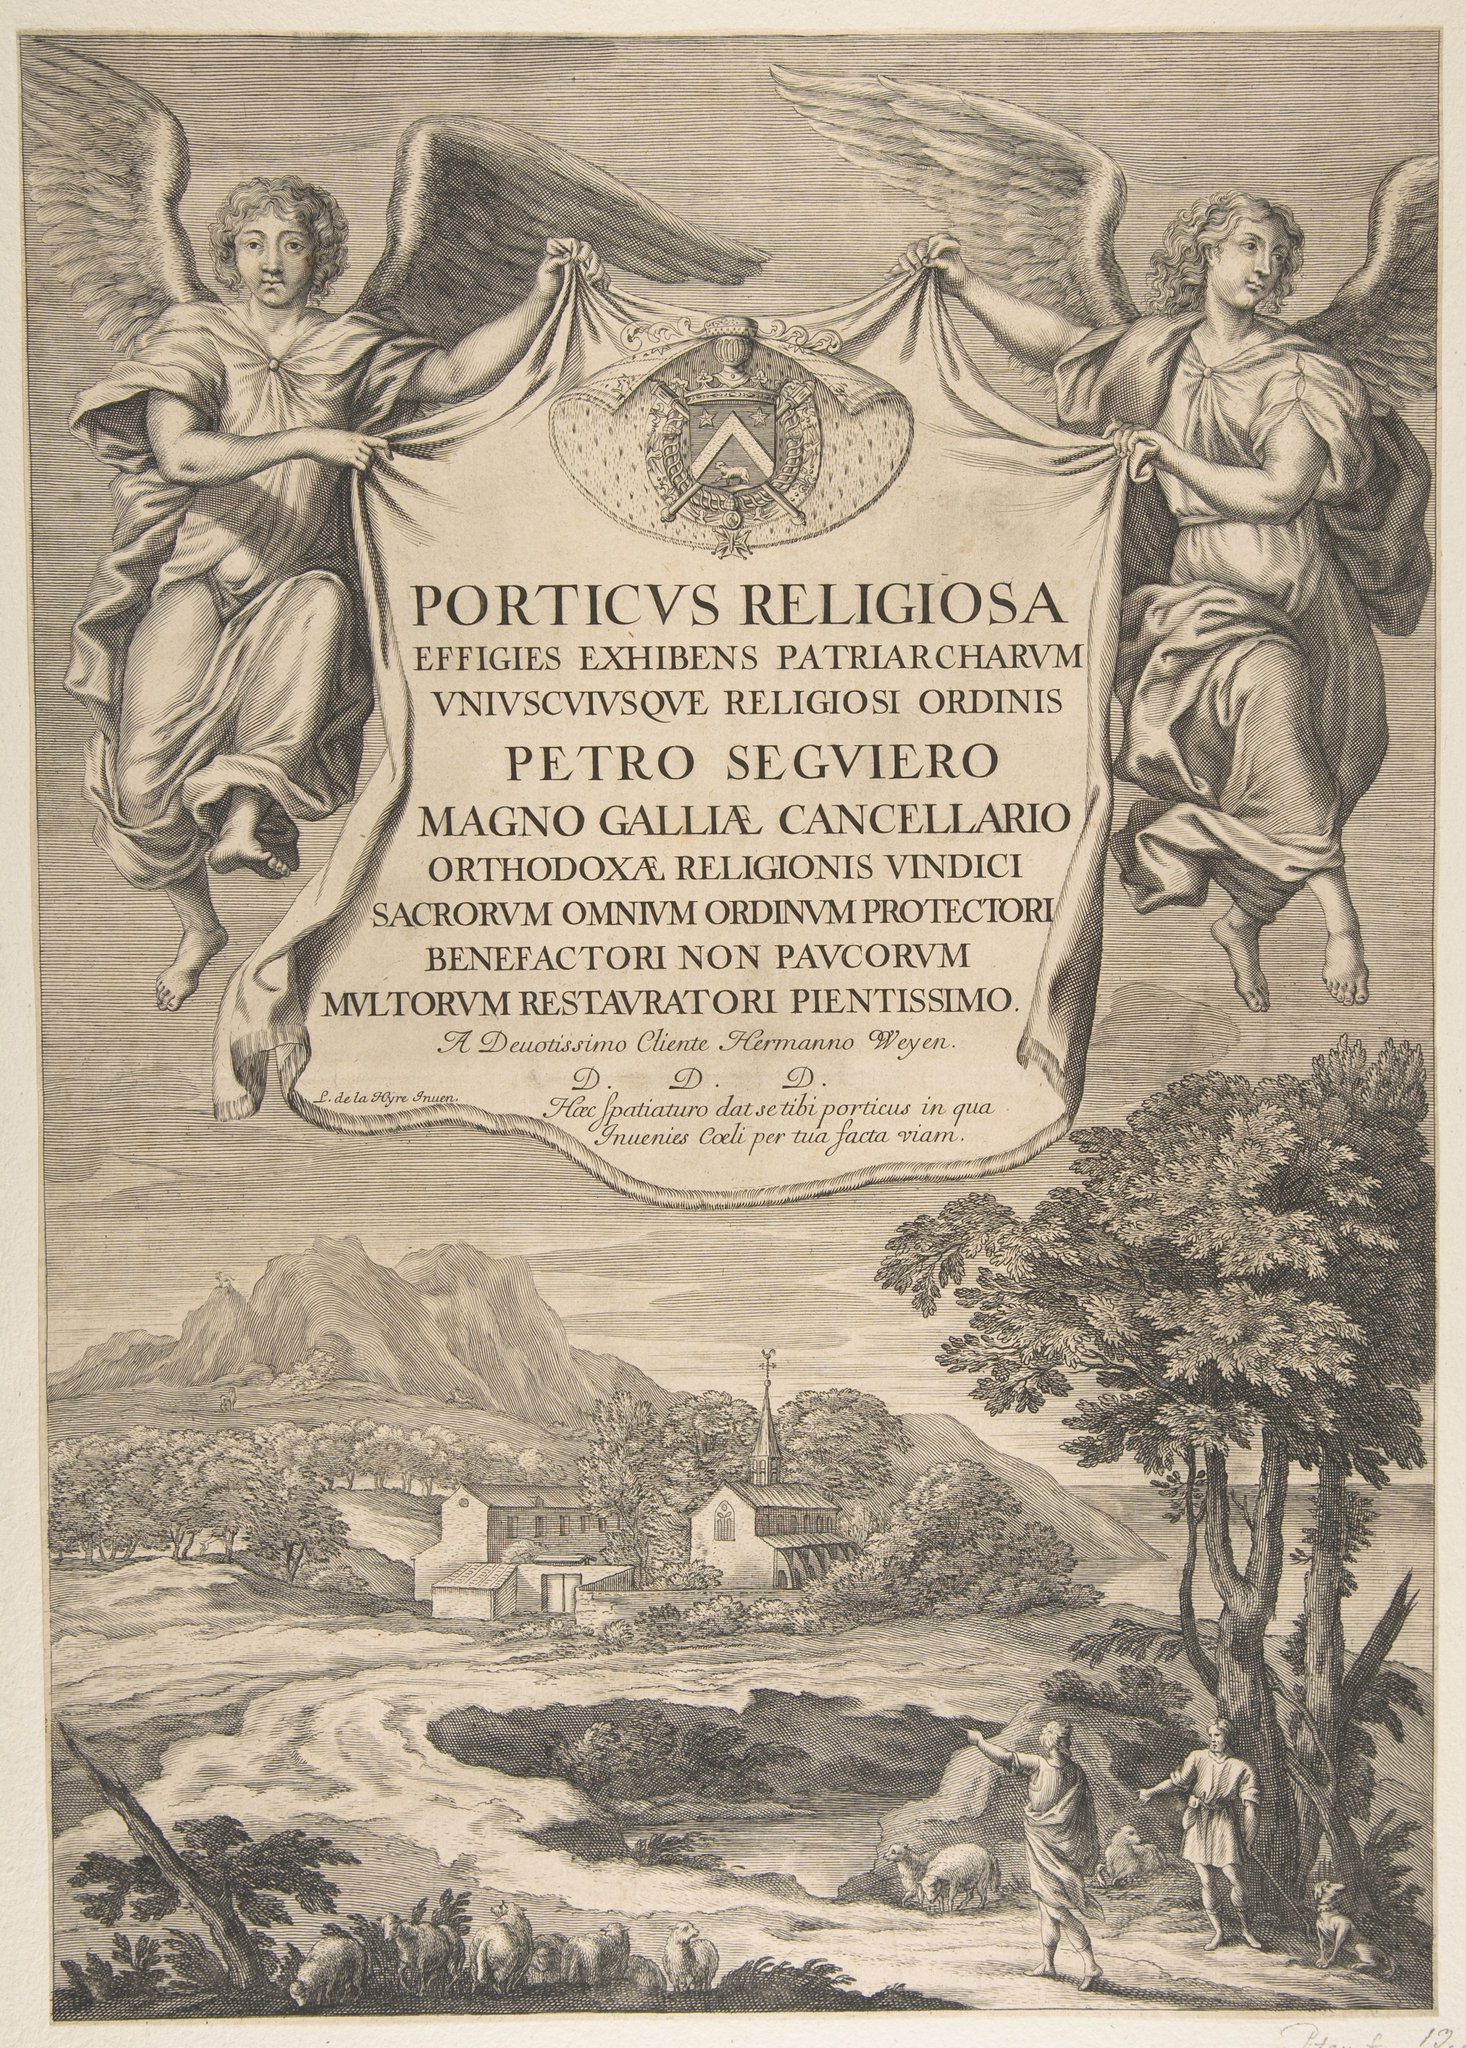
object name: print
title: Title Page for "Porticus Religiosa"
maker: nicolas pitau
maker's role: artist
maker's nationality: french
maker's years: 1670-1724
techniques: engraving, etching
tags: human figures,coat of arms